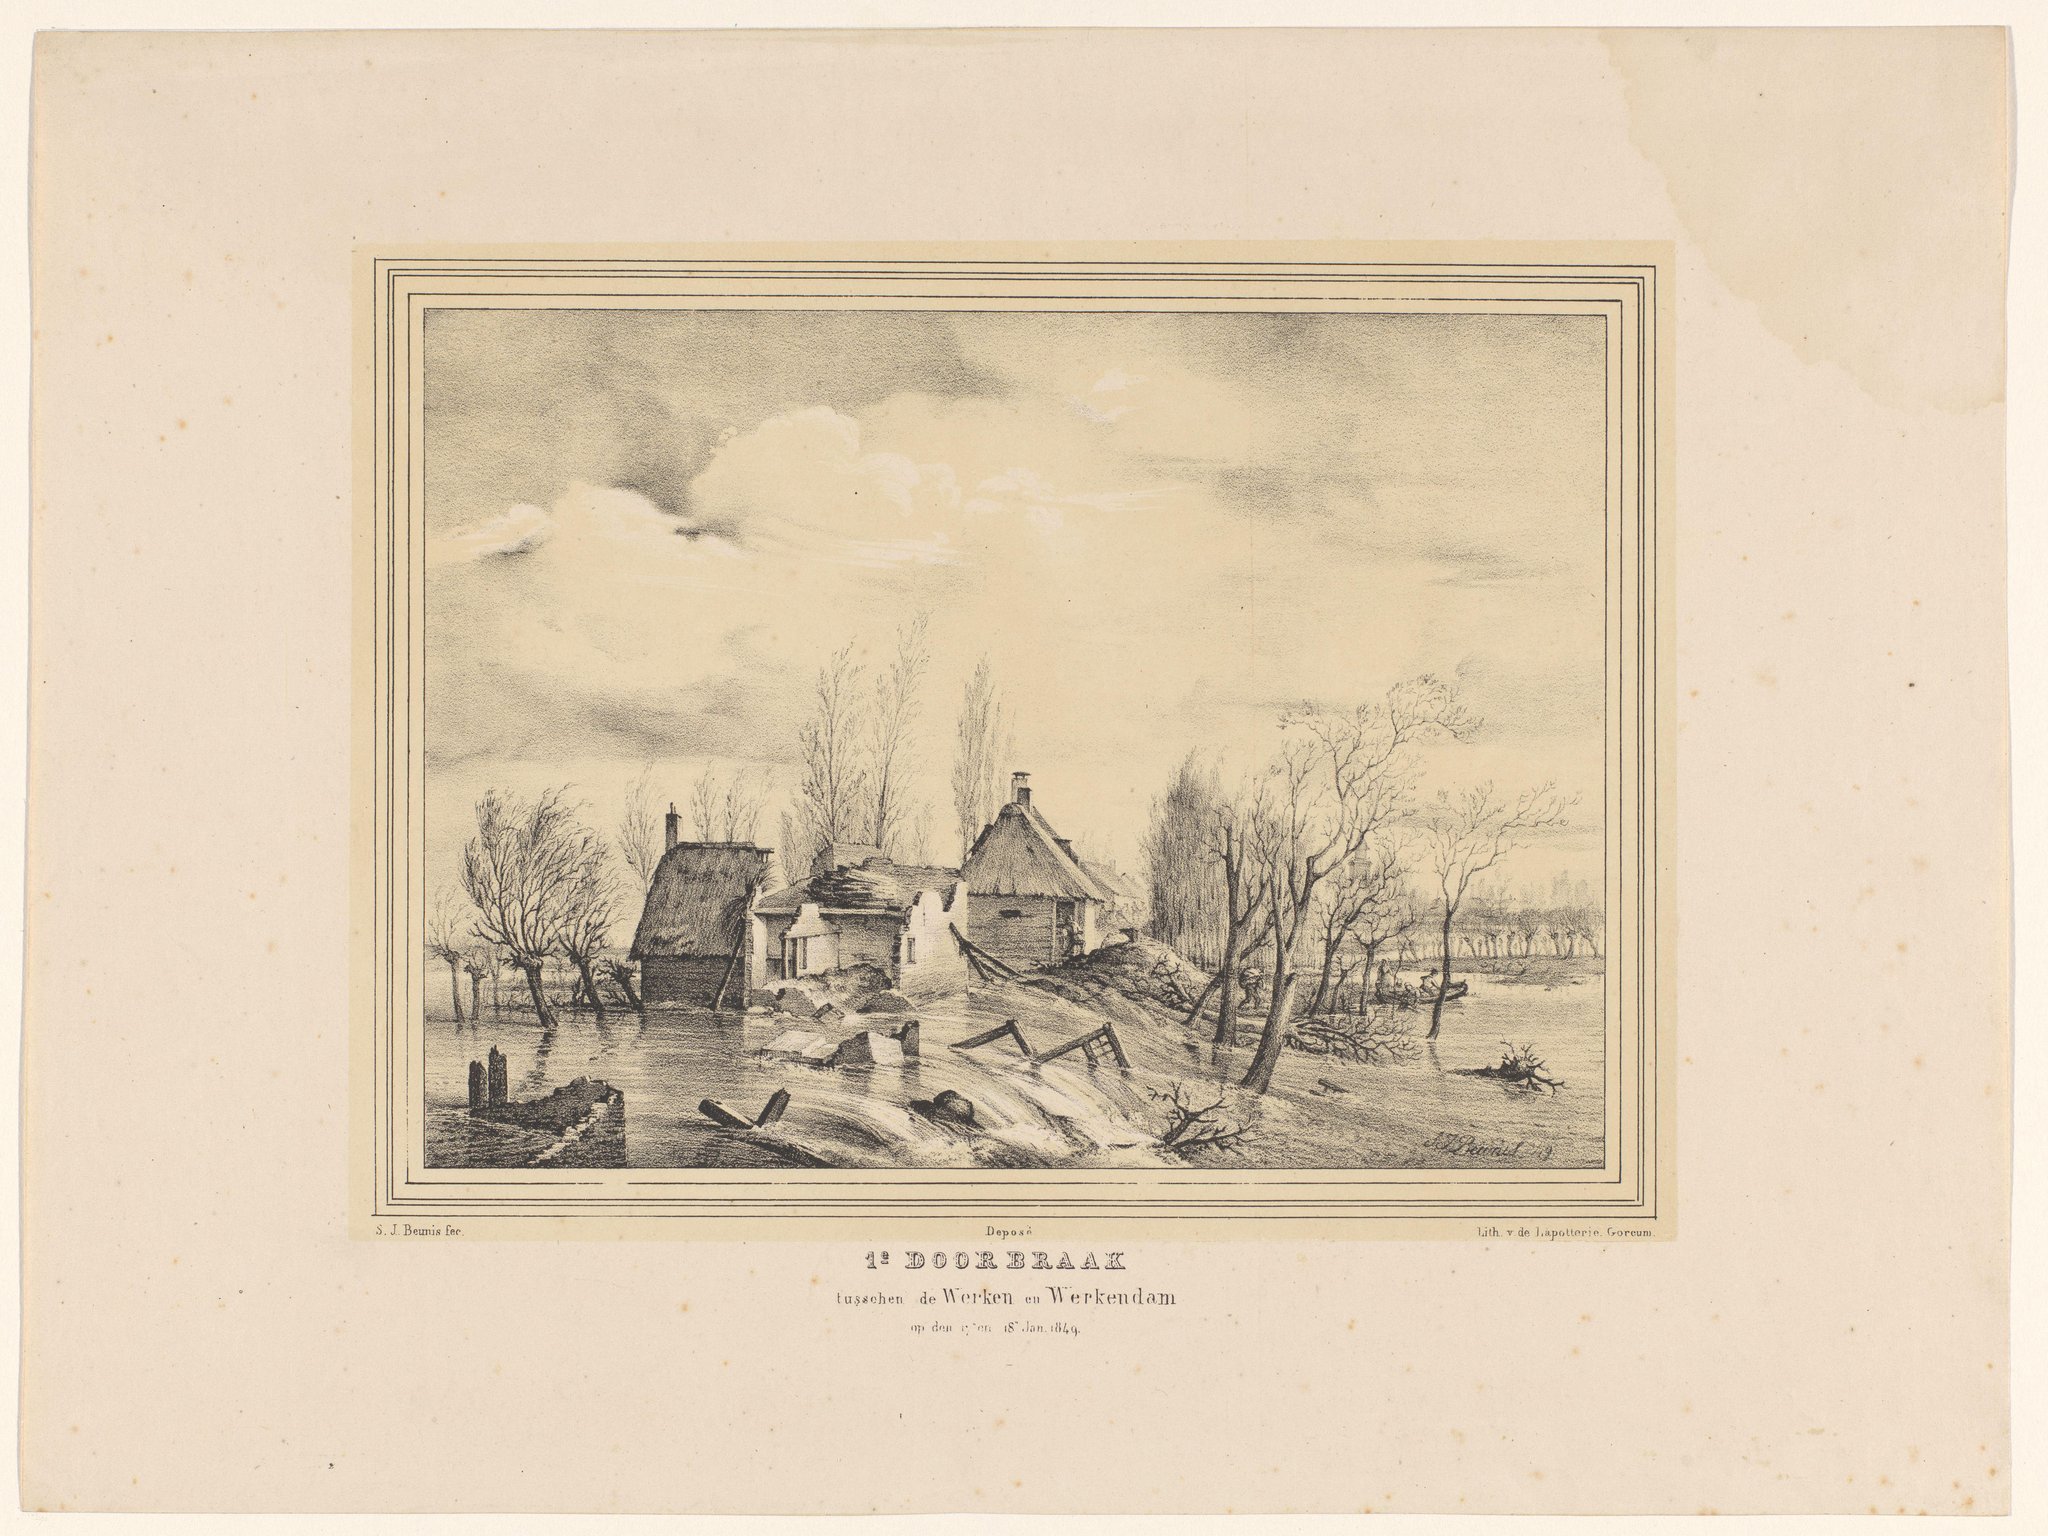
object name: print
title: 1e Doorbraak tusschen de Werken en Werkendam op den 17 en 18 Jan. 1849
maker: johannes beunis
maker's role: print maker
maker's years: 1809-1867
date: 1849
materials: ink, paper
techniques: tone lithography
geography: netherlands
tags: dike-break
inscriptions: collector's mark: Lugt 2228, collector's mark: Lugt 2760, : ‘Deposé’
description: Eerste doorbraak tussen Werkendam en de Werken op 17 en 18 januari 1849.